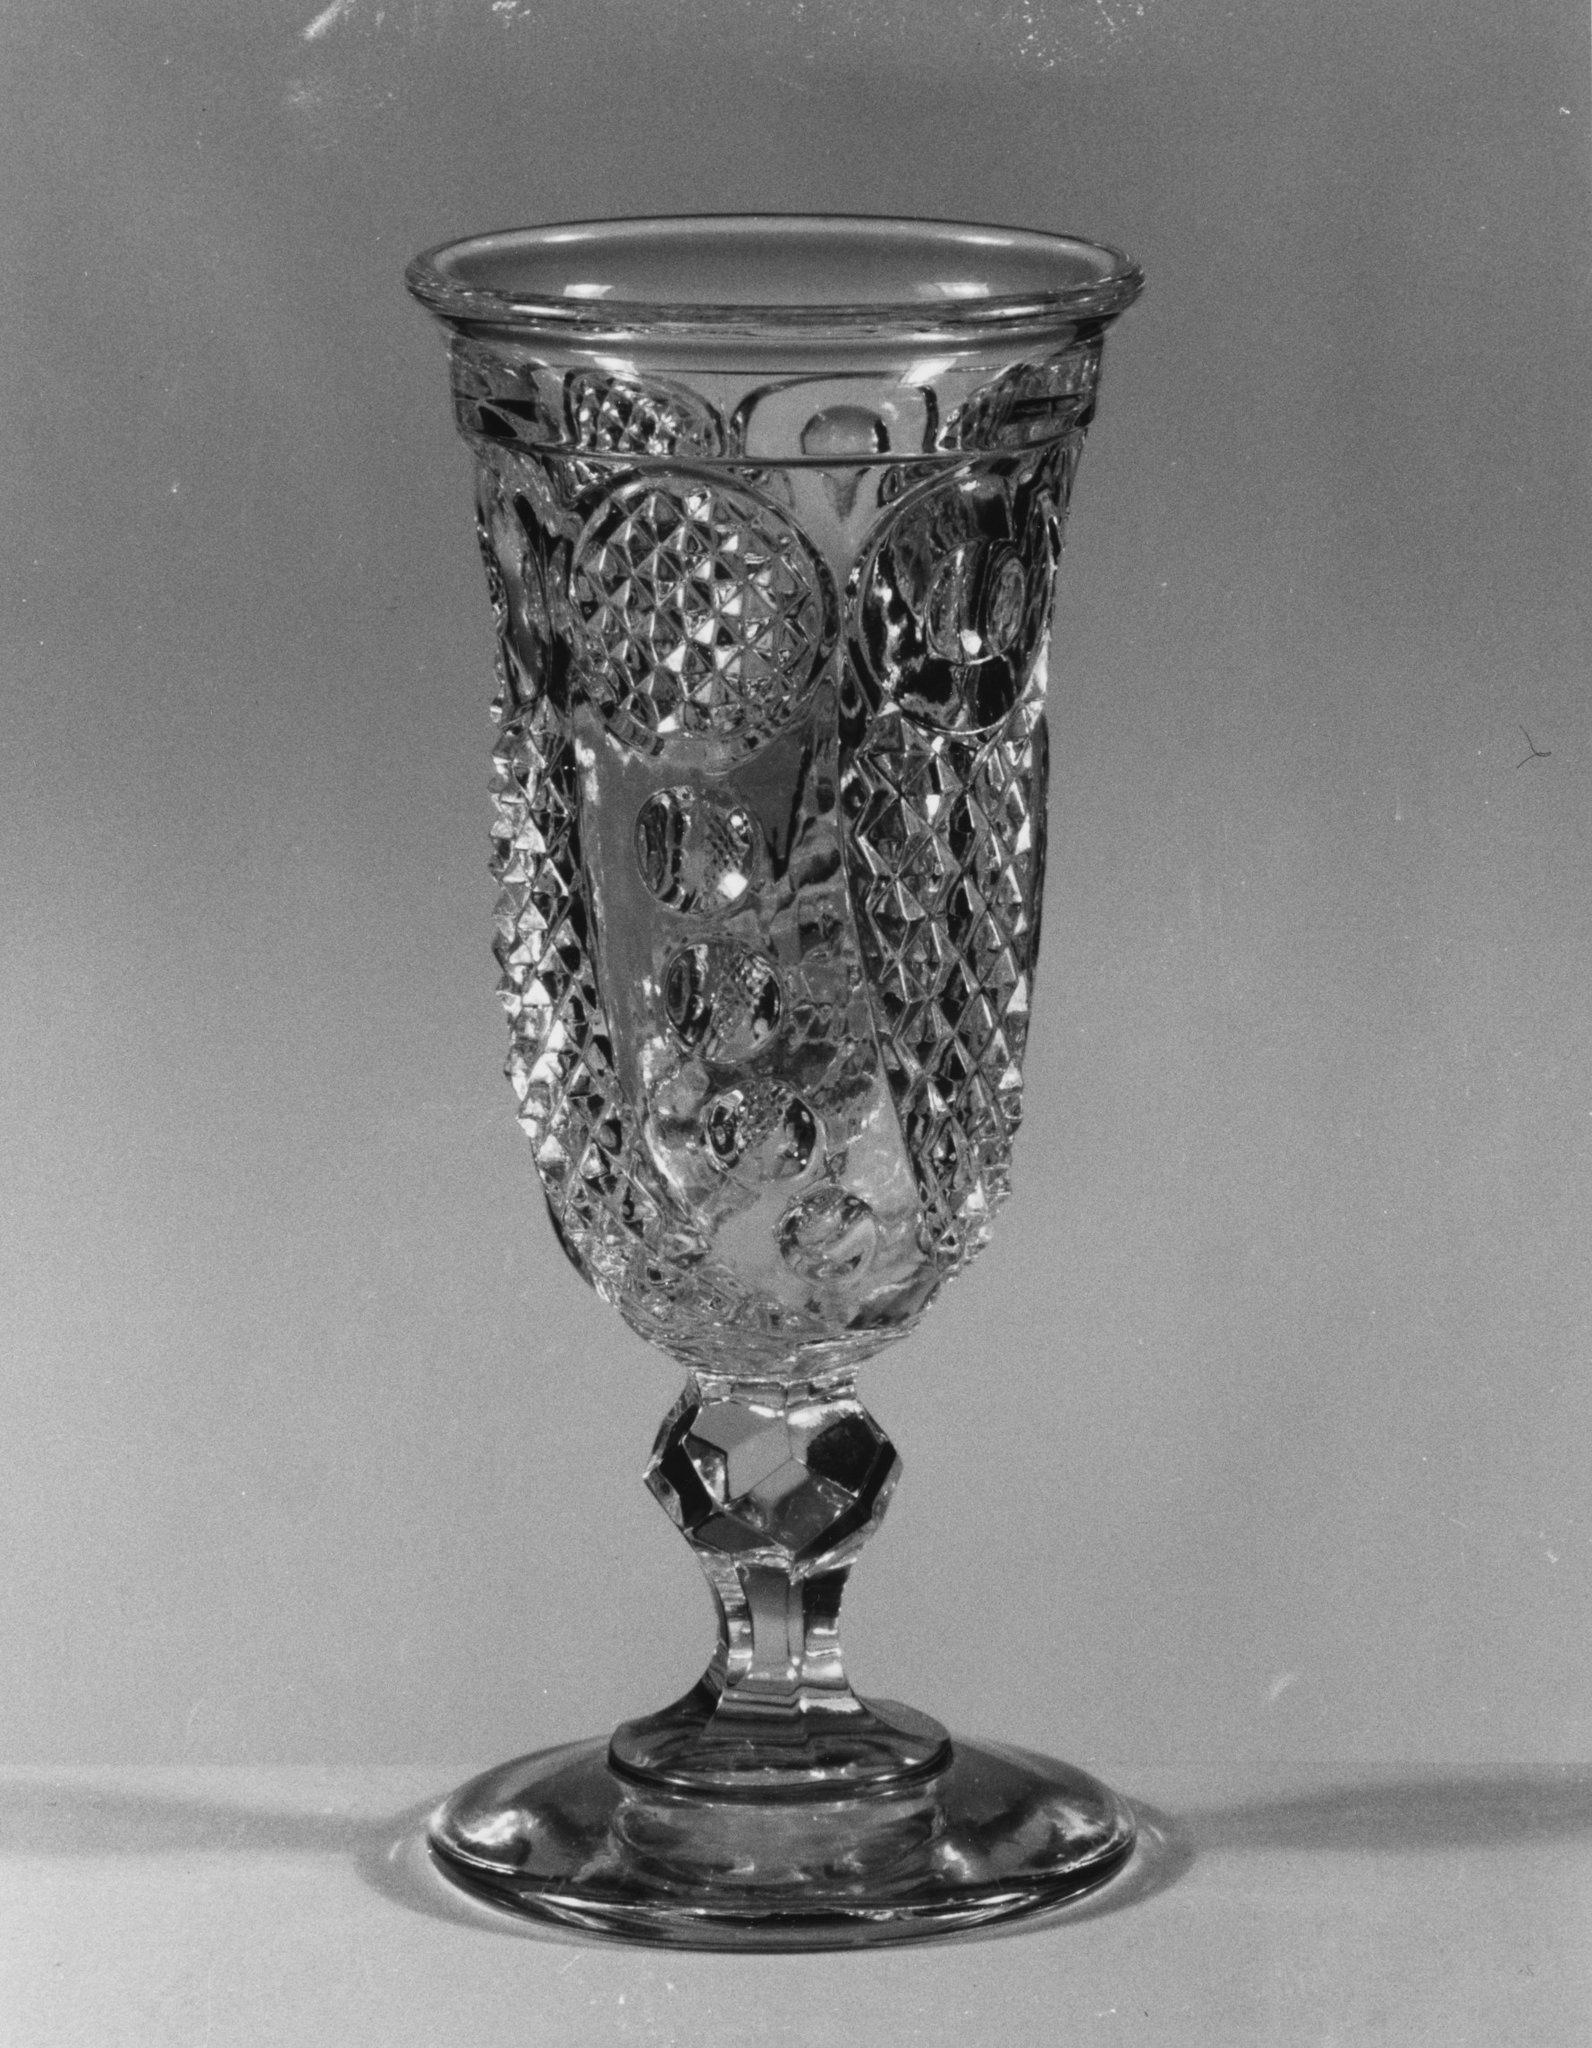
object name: claret glass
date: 1850-1870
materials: glass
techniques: pressed